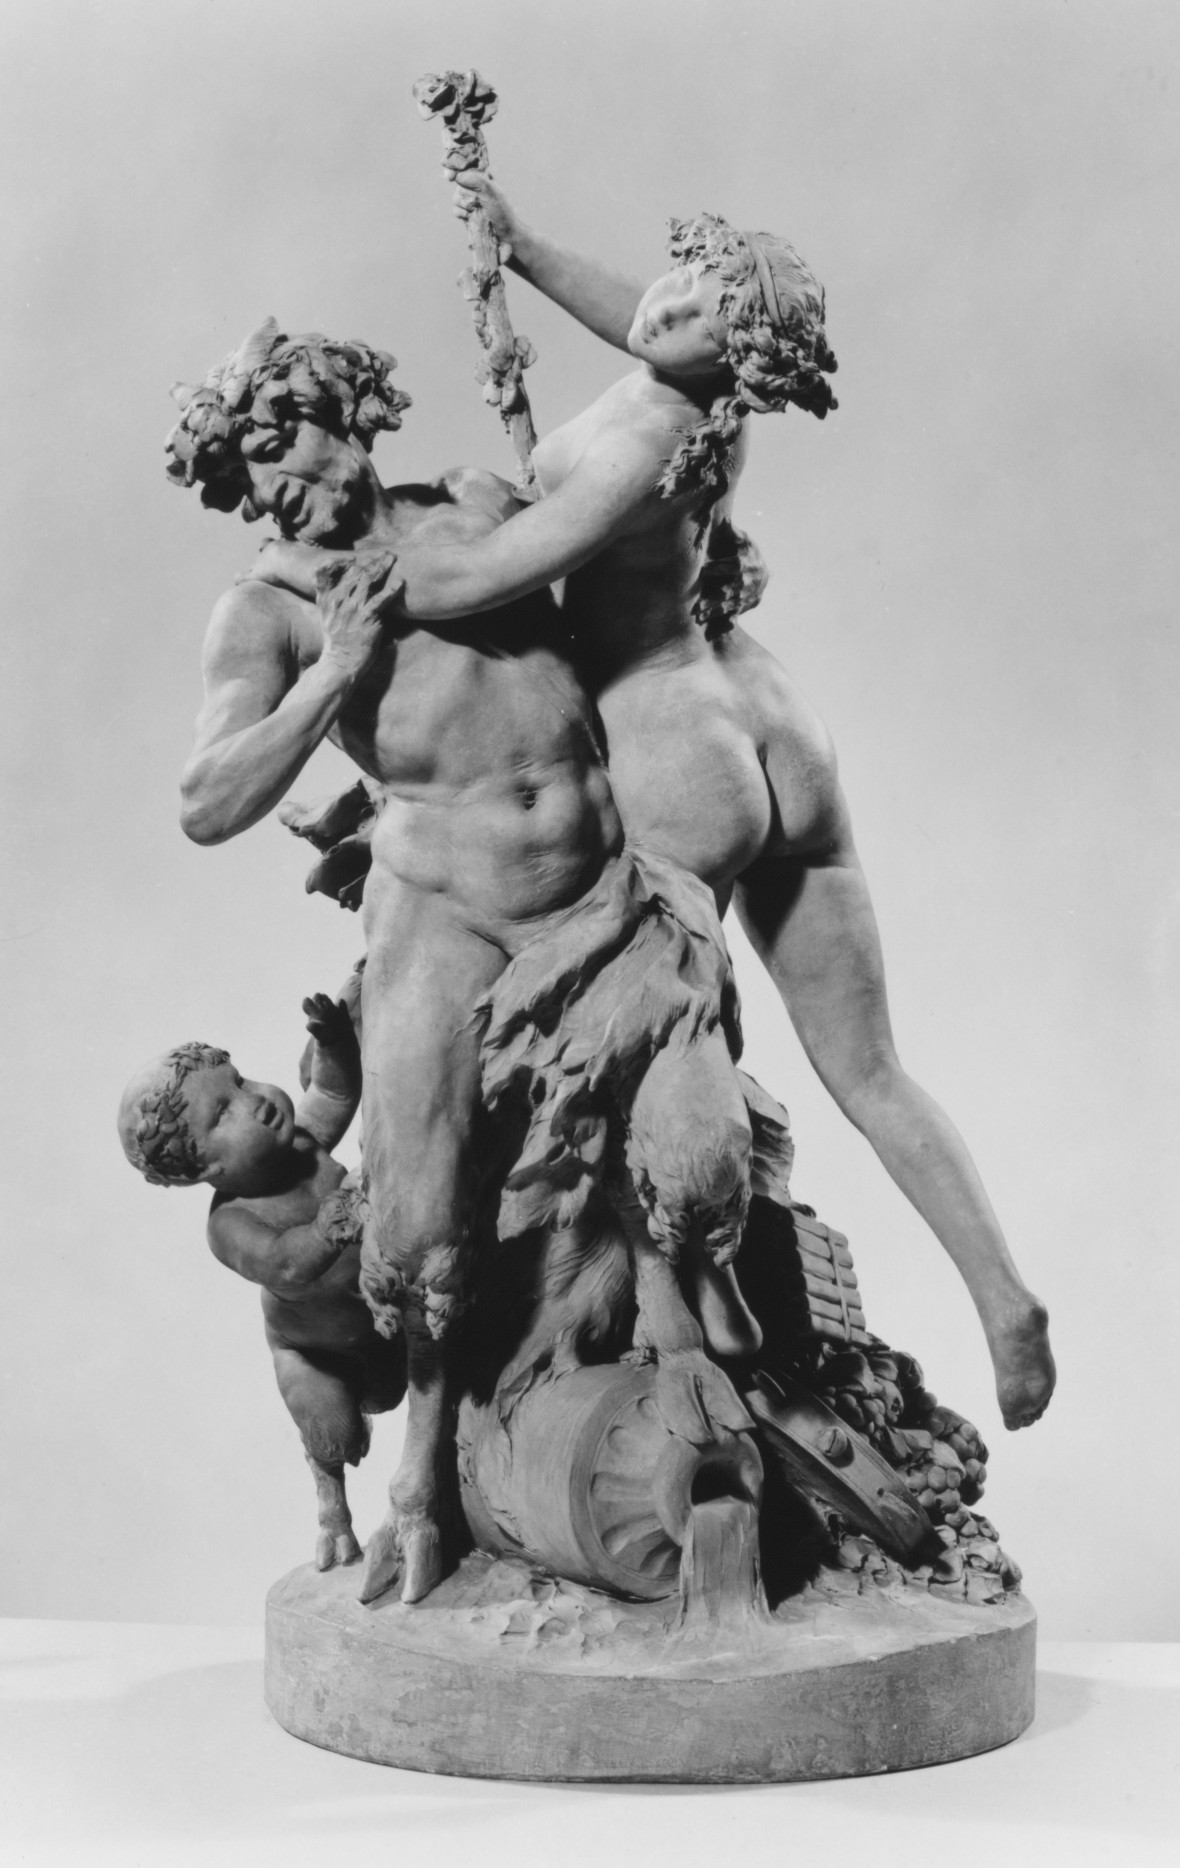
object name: statuette group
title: Bacchic group: satyr and bacchante with infant satyr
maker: clodion (claude michel)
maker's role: artist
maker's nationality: french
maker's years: 1738-1814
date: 1767-1800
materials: terracotta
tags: infants,bacchantes,satyrs